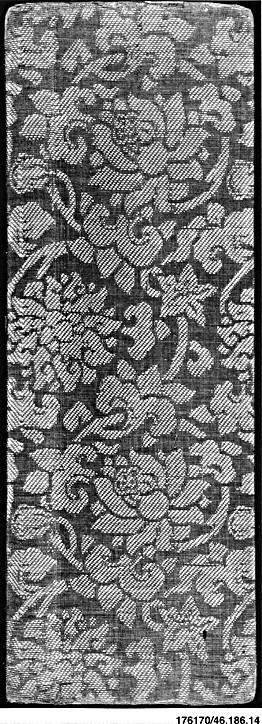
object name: sutra cover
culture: chinese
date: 1501-1600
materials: silk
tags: flowers